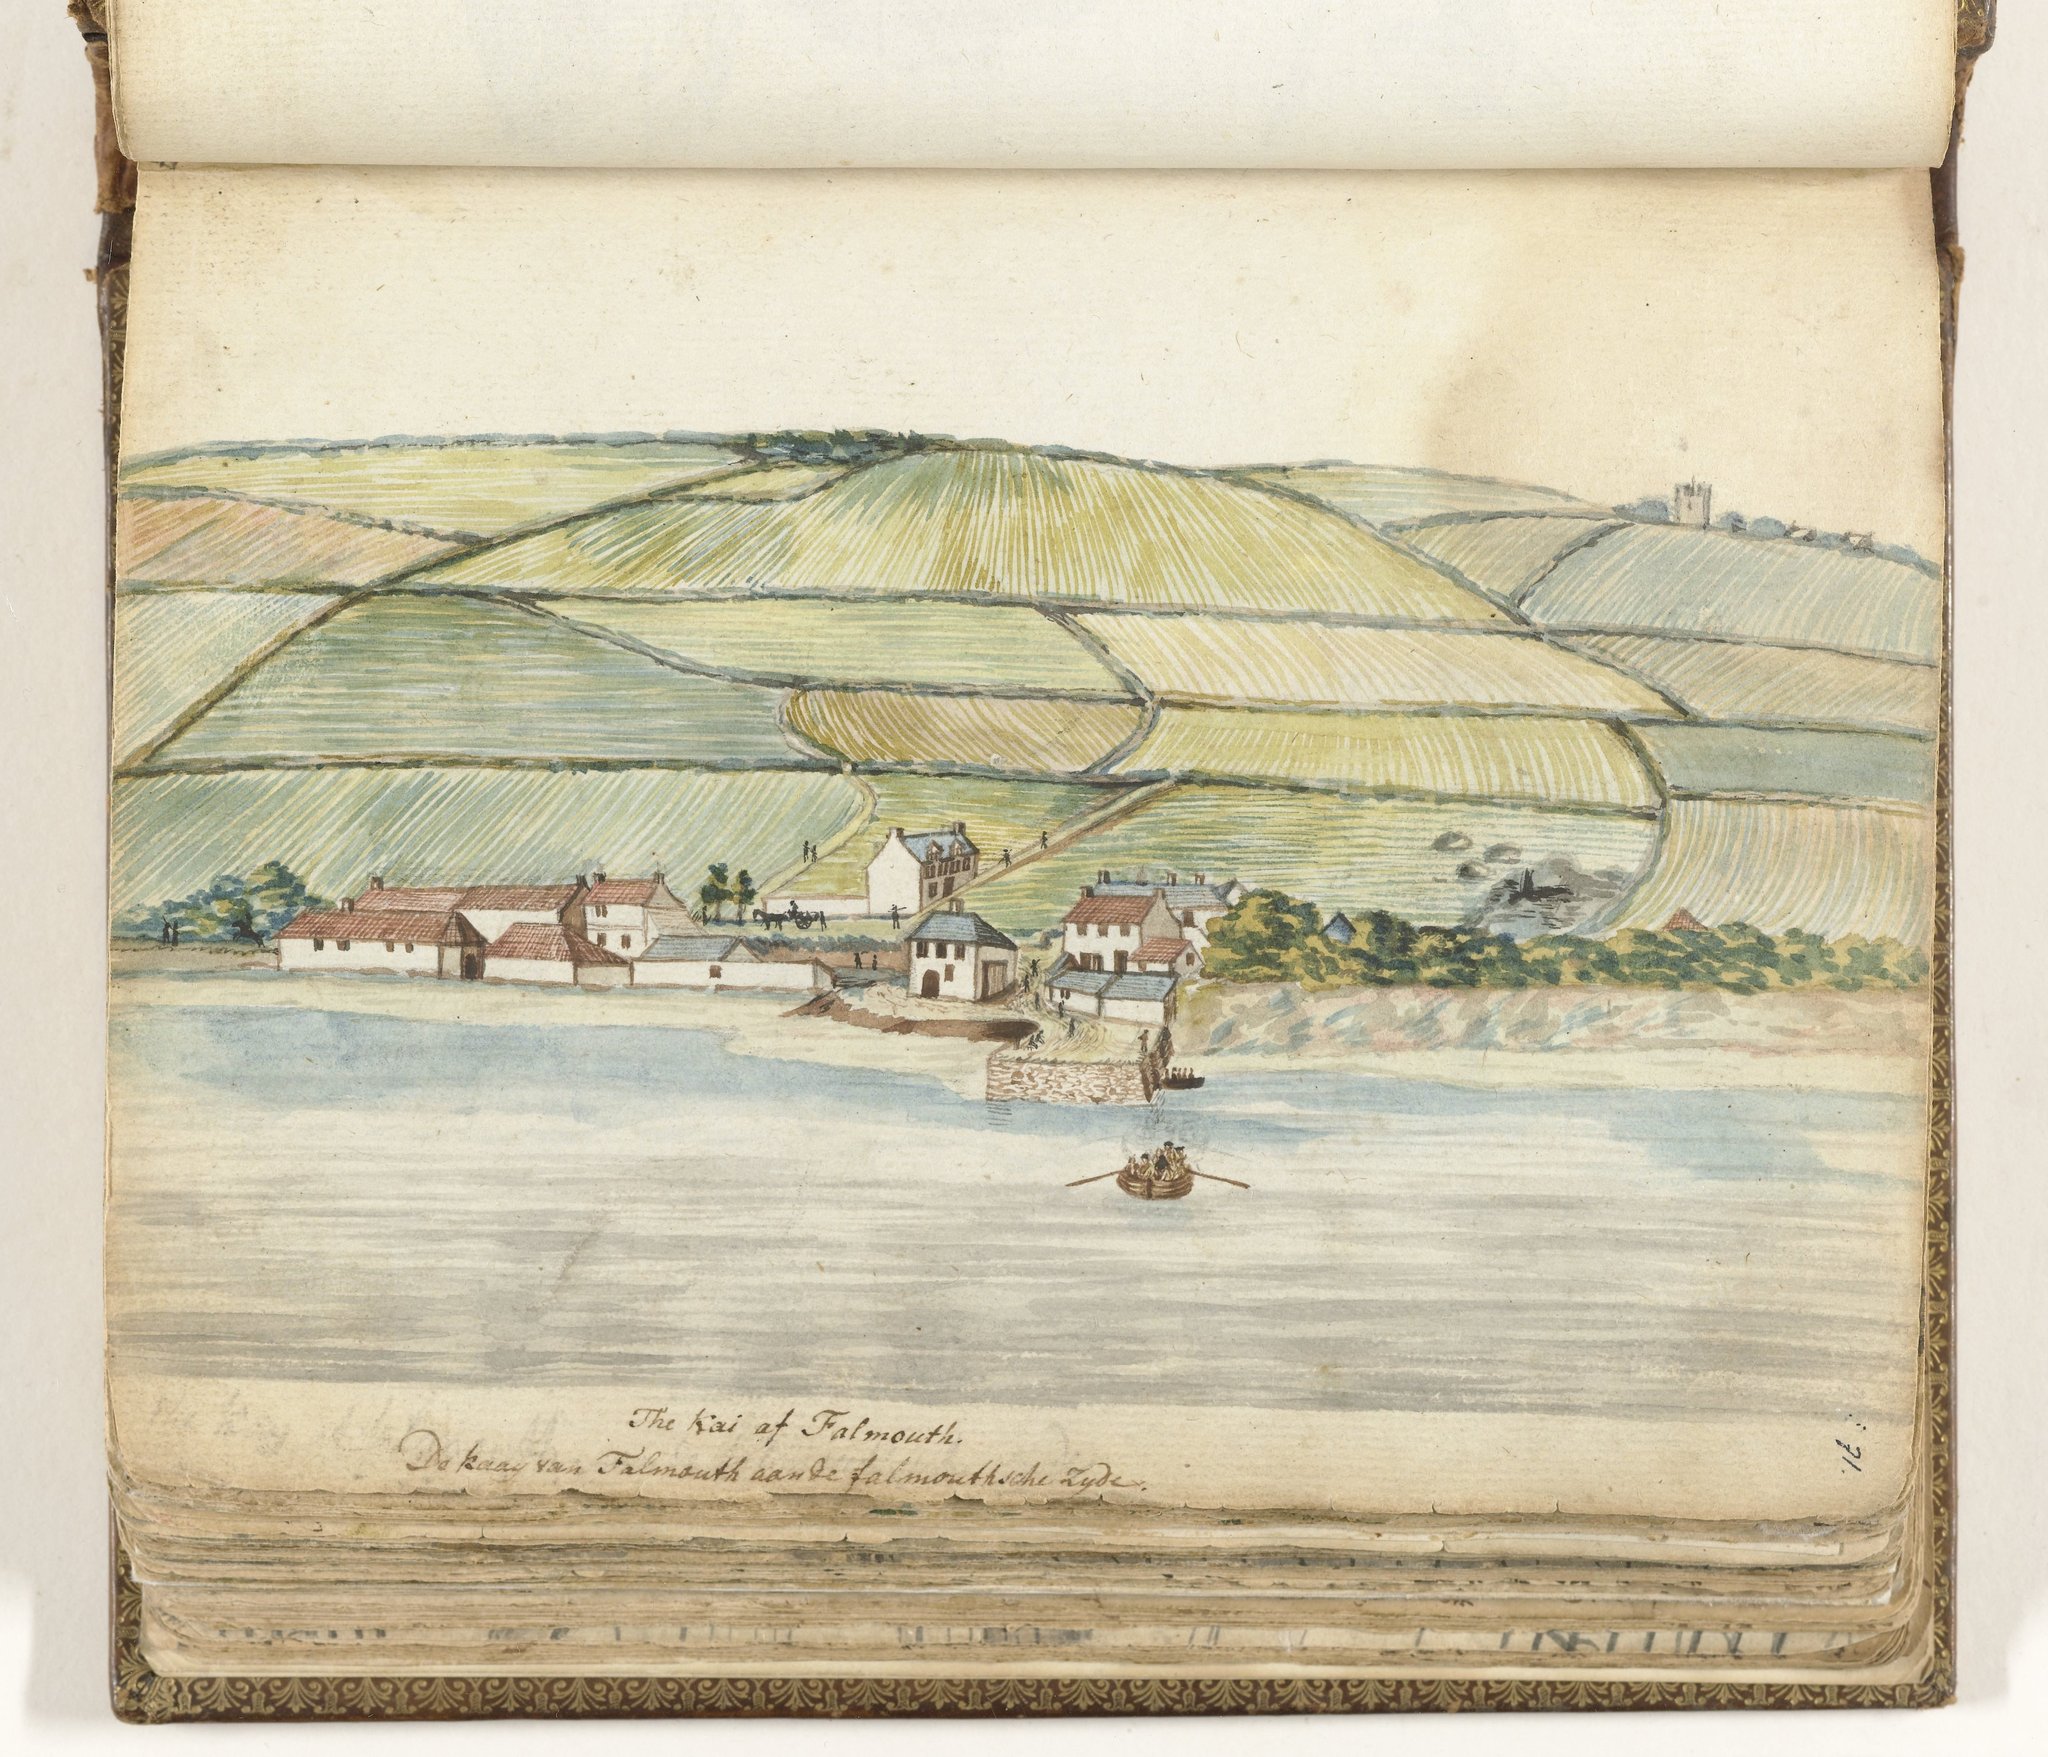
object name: drawing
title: Kade van Falmouth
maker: jan brandes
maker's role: draughtsman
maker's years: 1743-1808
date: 1706-1778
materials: paper, pencil, watercolor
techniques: brush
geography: falmouth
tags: harbour, prospect of village, silhouette of village, rowing-boat, canoe, etc., coast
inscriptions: inscription: ‘The kai af Falmouth De kaay van Falmouth aan de falmouthsche zyde.’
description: Kleurtekening van een kade met huizen en glooiend oplopende groene kust. De tekening is gemaakt vanaf de voor anker liggende Oostindiëvaarder 'Holland'. Een sloep vaart mensen naar de wal. Met opschrift. Onderdeel uit het schetsboek van Jan Brandes, dl. 2 (1808), p. 71.